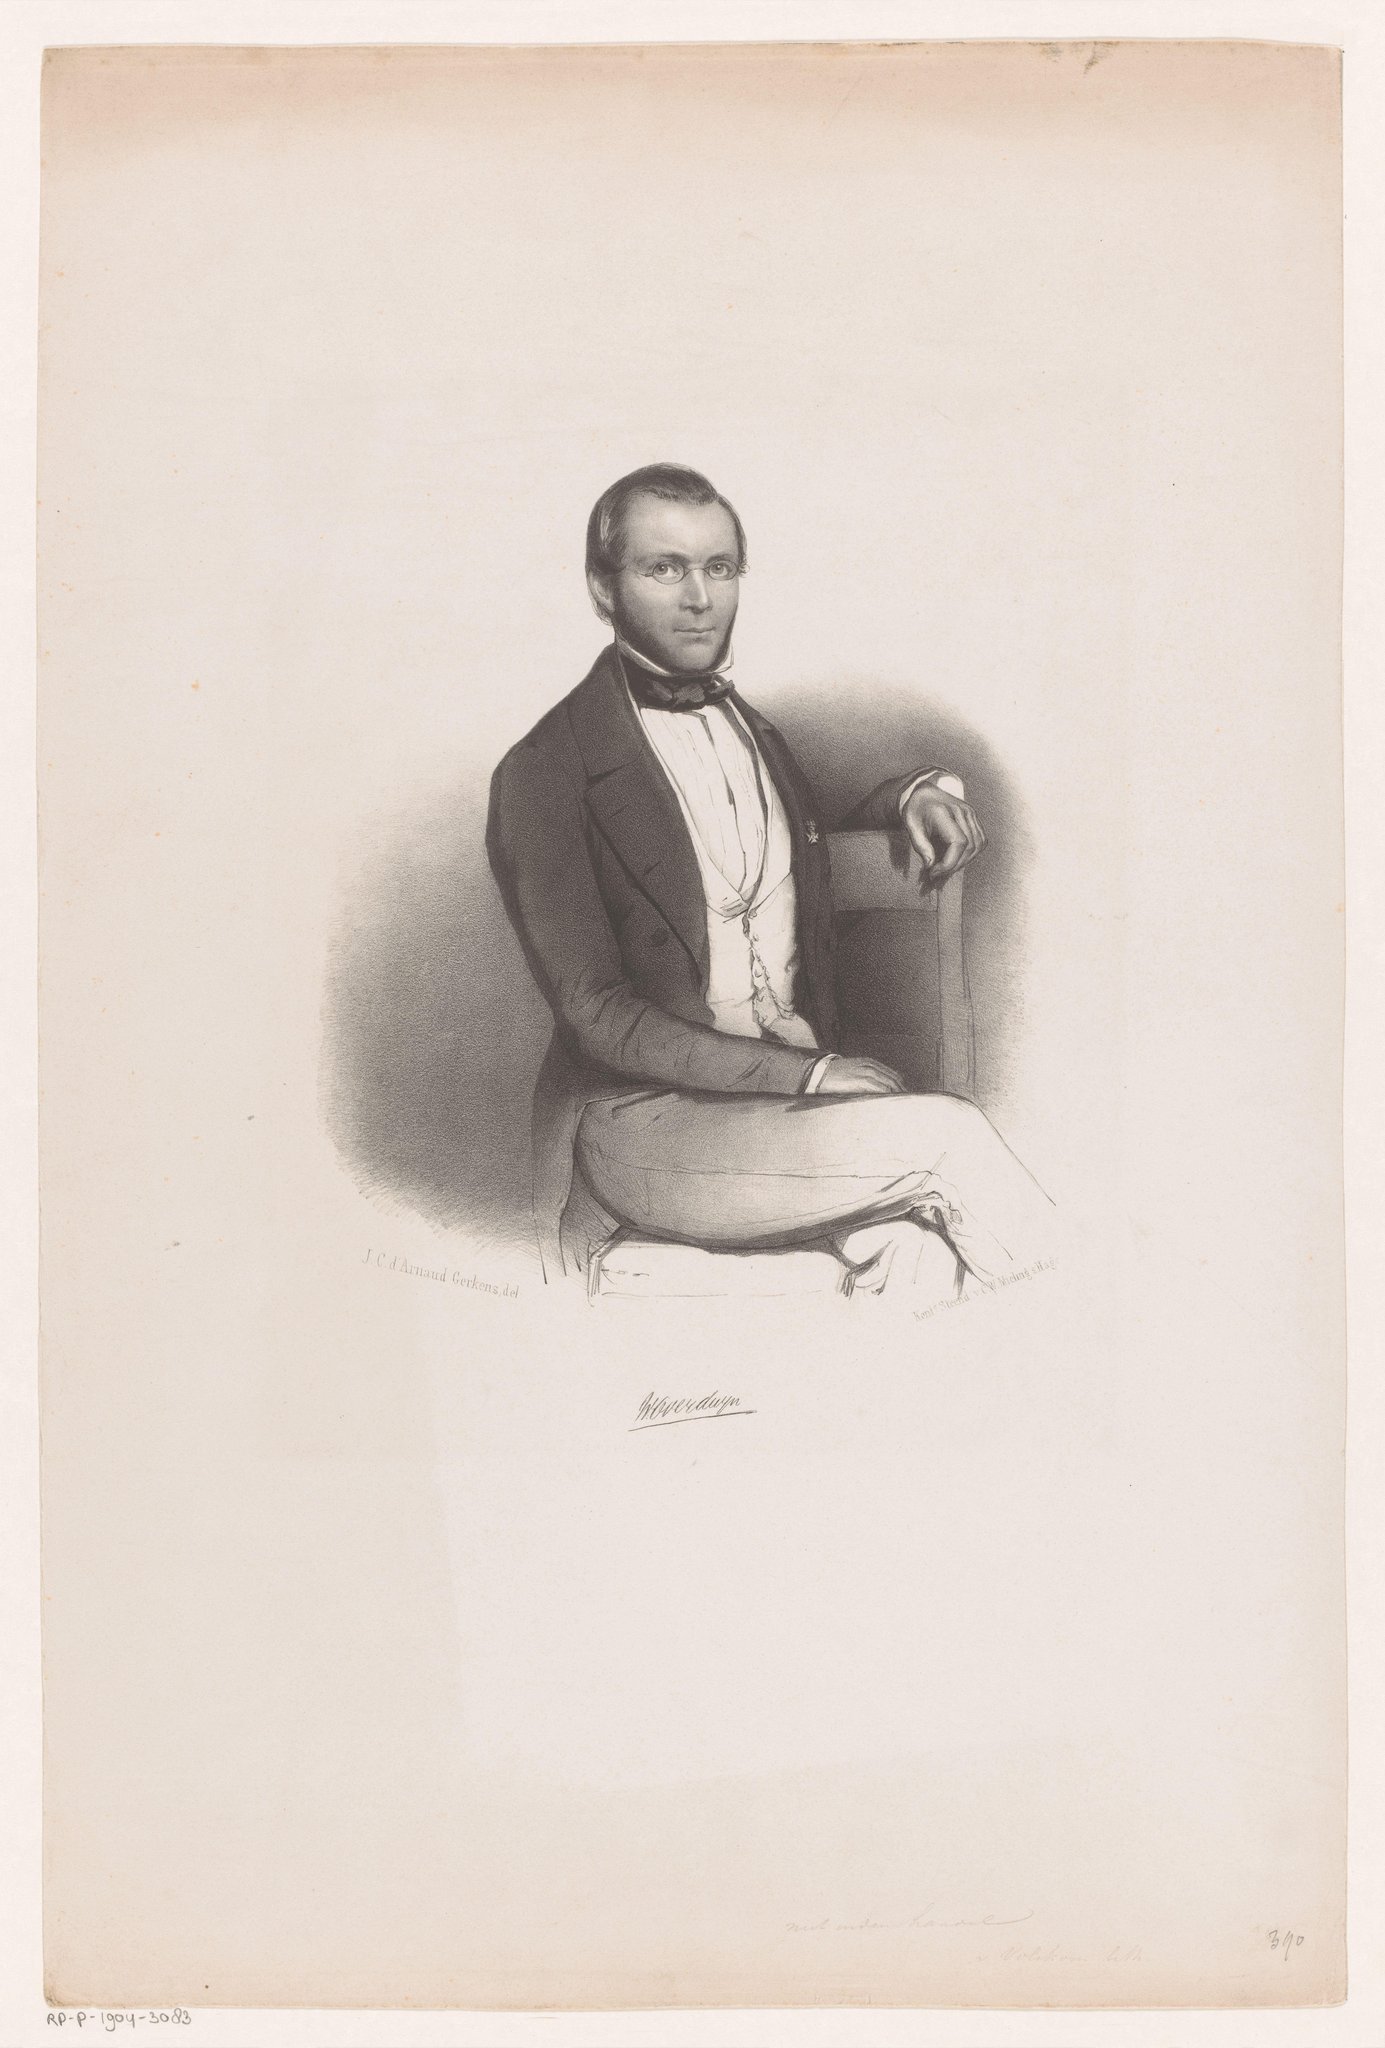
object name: print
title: Portret van Willem Lodewijk Overduyn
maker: johannes christiaan d arnaud gerkens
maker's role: draughtsman, print maker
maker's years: 1823-1892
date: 1833-1868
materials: paper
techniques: lithograph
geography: netherlands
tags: flushing, delft, draughtsman, eyeglasses, spectacles, knighthood order, historical persons (+ half-length portrait)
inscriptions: inscription: ‘Niet inden handel / v (...) lith’, collector's mark: Lugt 2228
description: De geportretteerde zit op een stoel en heeft zijn benen over elkaar geslagen. Hij draagt een bril en een ridderorde. Onder het portret zijn signatuur.